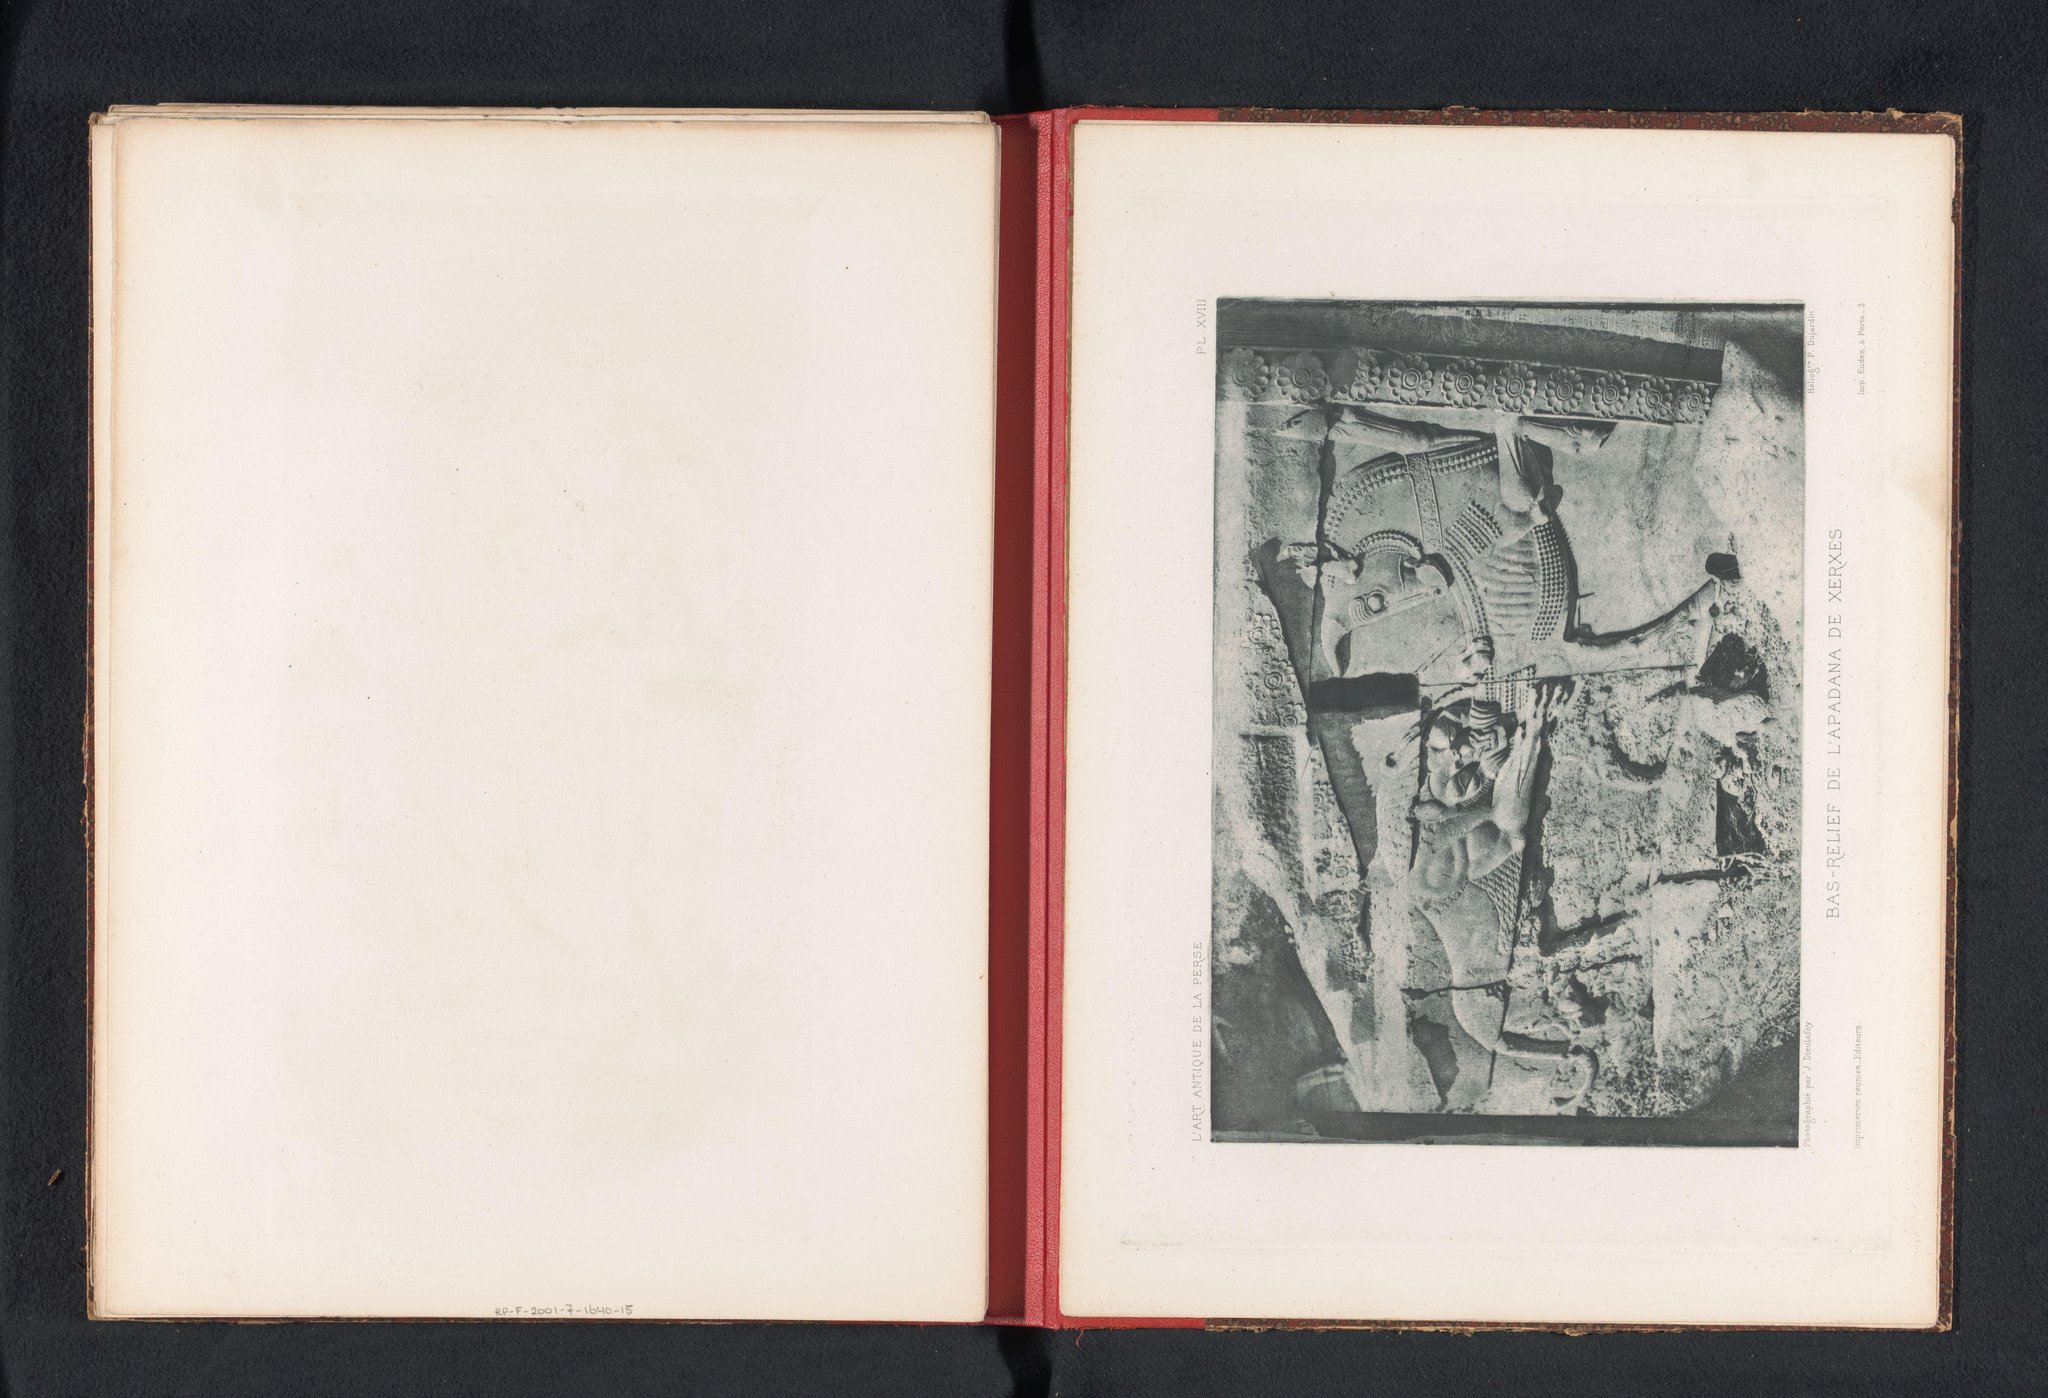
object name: photomechanical print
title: L'Art Antique de la Perse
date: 1880-1885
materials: paper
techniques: photoaquatint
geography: takht-e jamshid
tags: ox, beasts of prey, predatory animals: lion, sculpture (+ relief ~ sculpture)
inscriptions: inscription: ‘Imprimeries réunies_Editeurs. Imp. Eudes, à Paris_3.’, number: ‘PL. XVIII’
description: Deze prent maakt deel uit van een omslag met twintig prenten op zeventien bladen en vijftien tekstbladen.